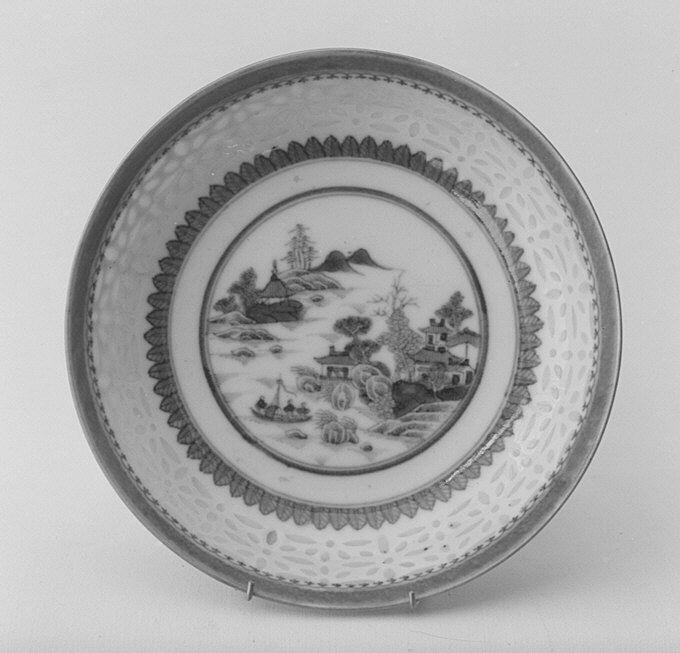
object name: saucer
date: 1801-1900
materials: hard paste porcelain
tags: human figures,trees,boats